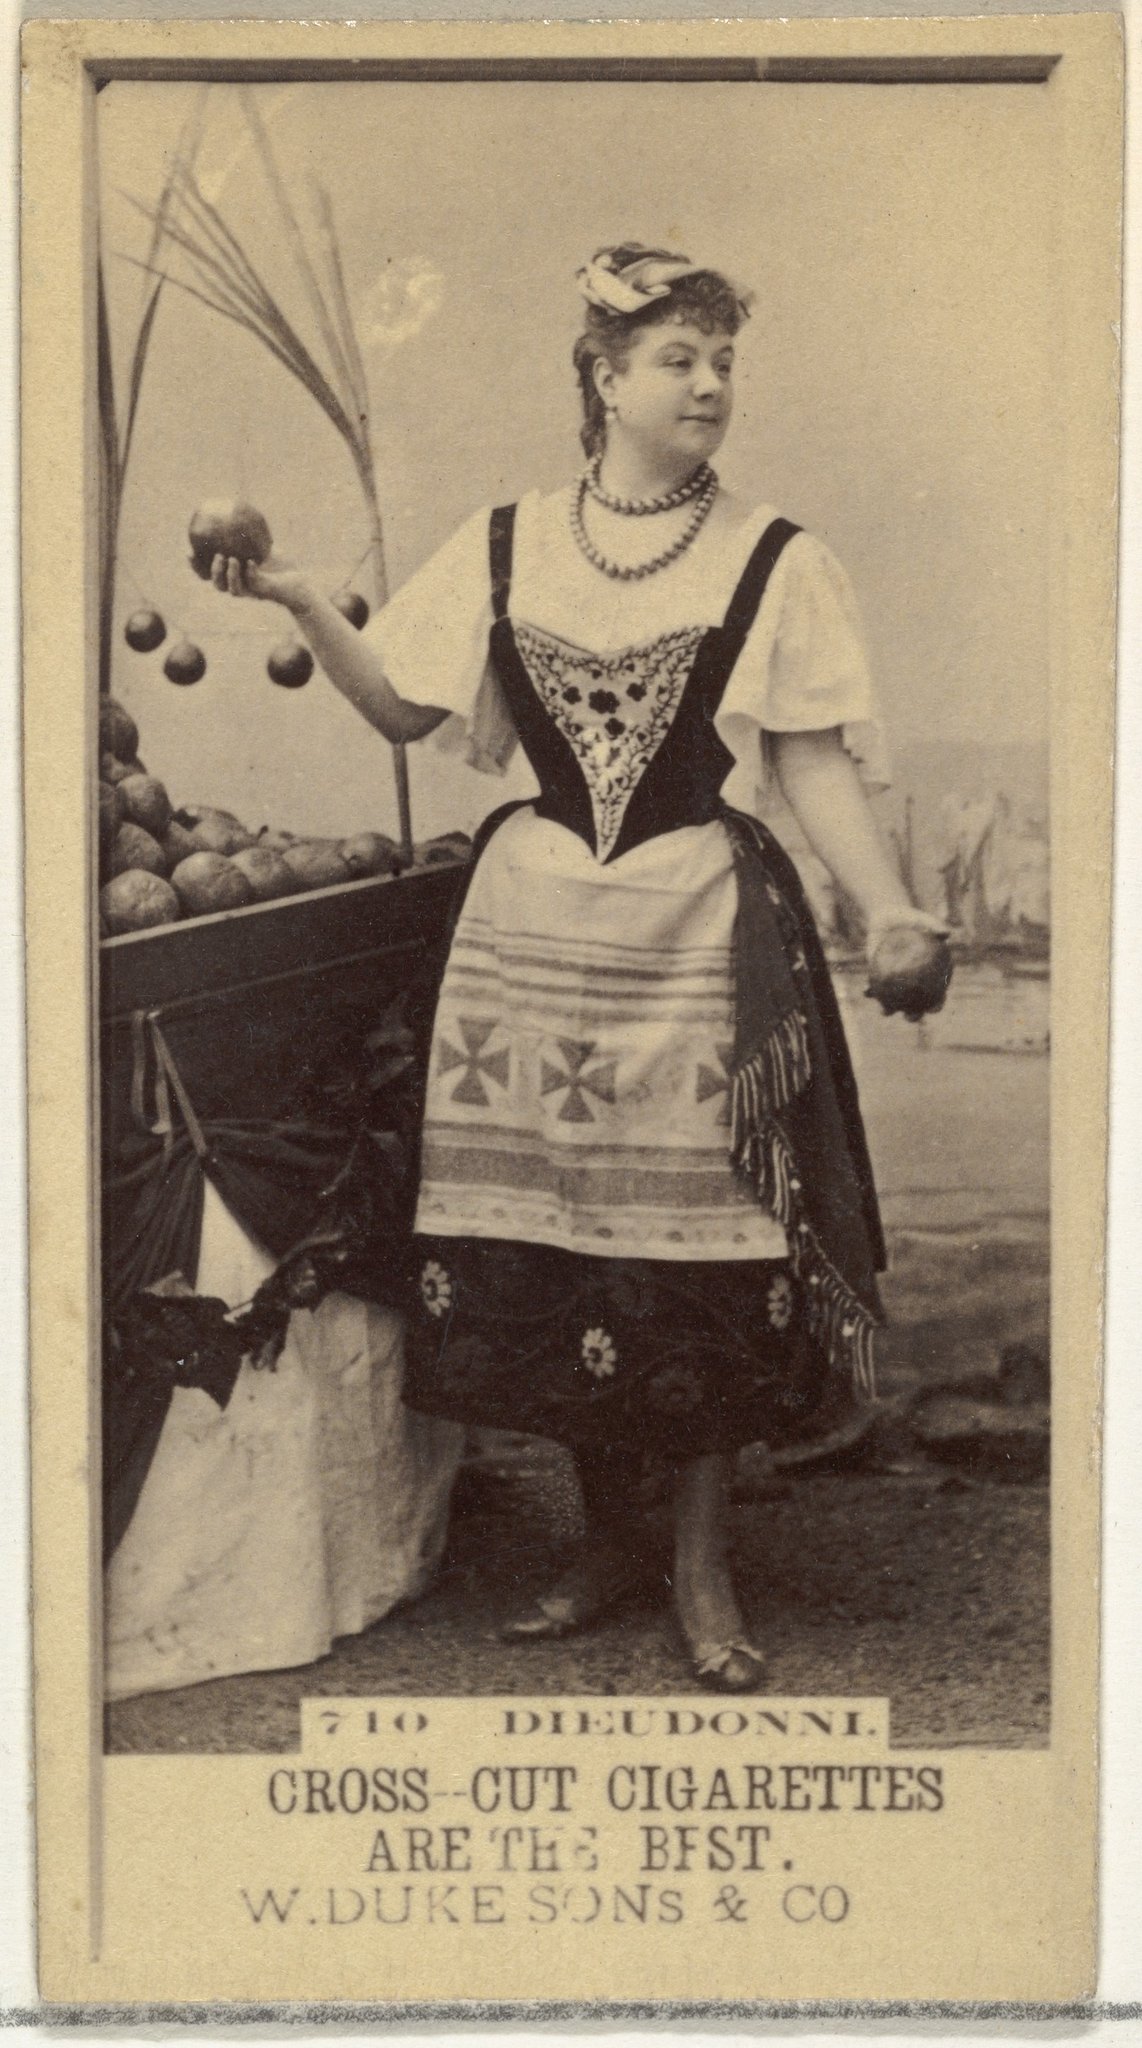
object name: photograph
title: Card Number 710, Dieudonni, from the Actors and Actresses series (N145-3) issued by Duke Sons & Co. to promote Cross Cut Cigarettes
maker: w. duke, sons & co.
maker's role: publisher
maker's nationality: american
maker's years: 1870-1920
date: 1880-1889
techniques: albumen silver print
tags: portraits,women,actresses